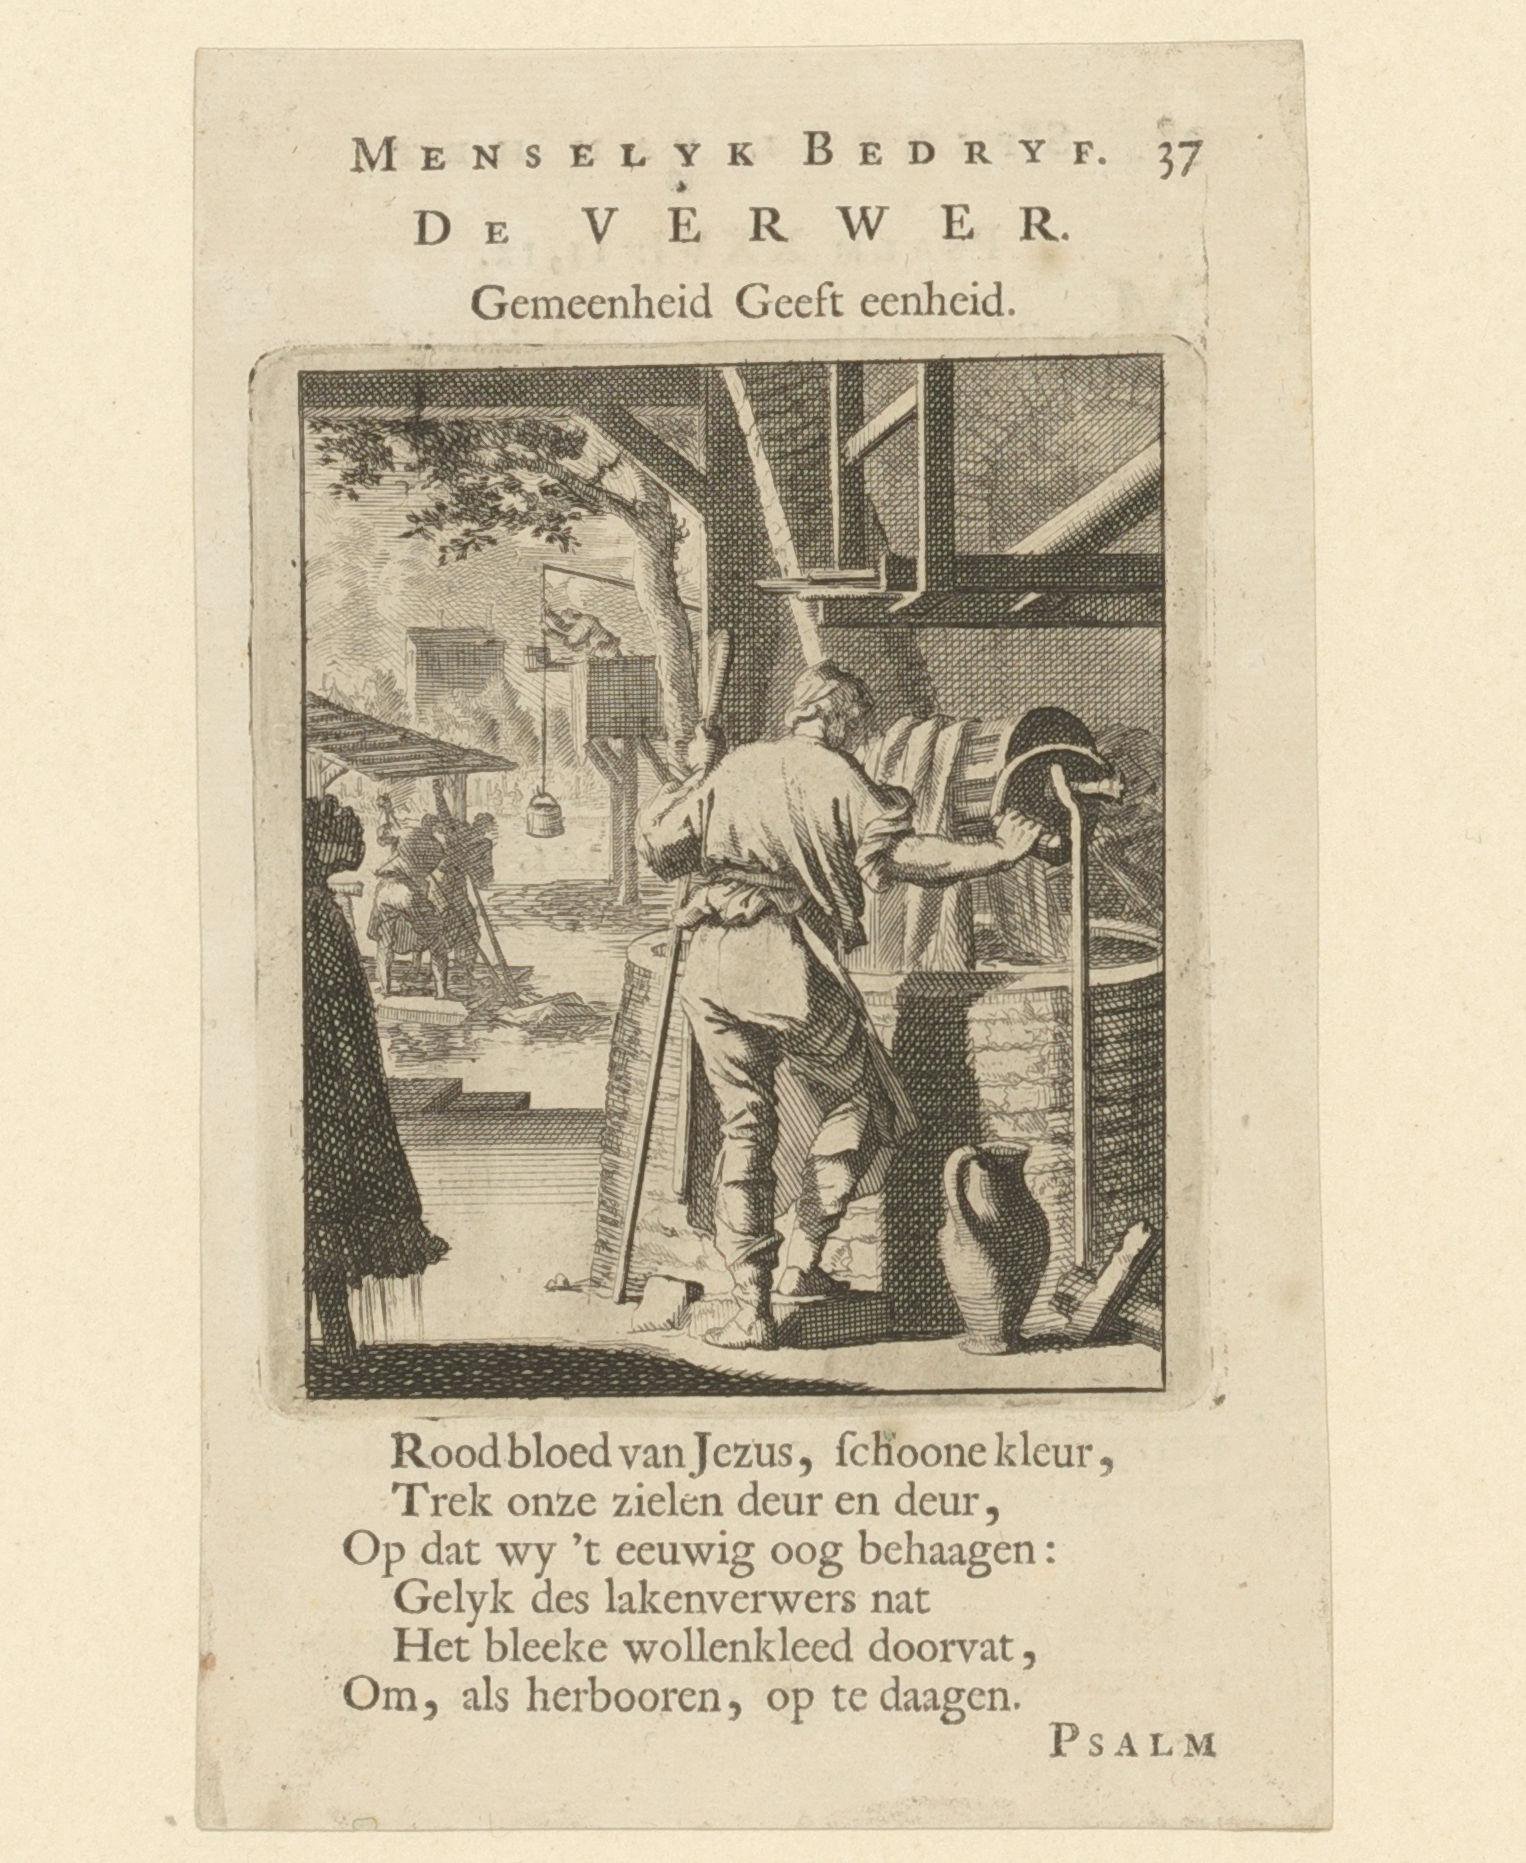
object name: book illustration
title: Lakenverver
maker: cornelis van der sys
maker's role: publisher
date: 1718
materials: paper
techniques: etching, letterpress printing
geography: amsterdam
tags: dyeing of cloth, handicrafts, craftsman at work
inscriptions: stamp, stamp, collector's mark: Lugt 1641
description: Prent oorspronkelijk verschenen in de 100-delige serie beroepsprenten van Jan en Caspar Luyken, getiteld: Het menselyk bedryf. S.l.s.n., 1694 (eerste druk). Daarna is de titel en het vers afgesneden. De prenten in diverse publicaties verschenen en gekopieerd. Huidige staat uit: Luyken, Jan en Caspar. Spiegel van het menselyk bedryf (...). Amsterdam: Cornelis van der Sys, 1718, p. 37. Prent waarschijnlijk ook gebruikt in eerdere (1704) en latere (1730, 1749, 1767) publicaties.